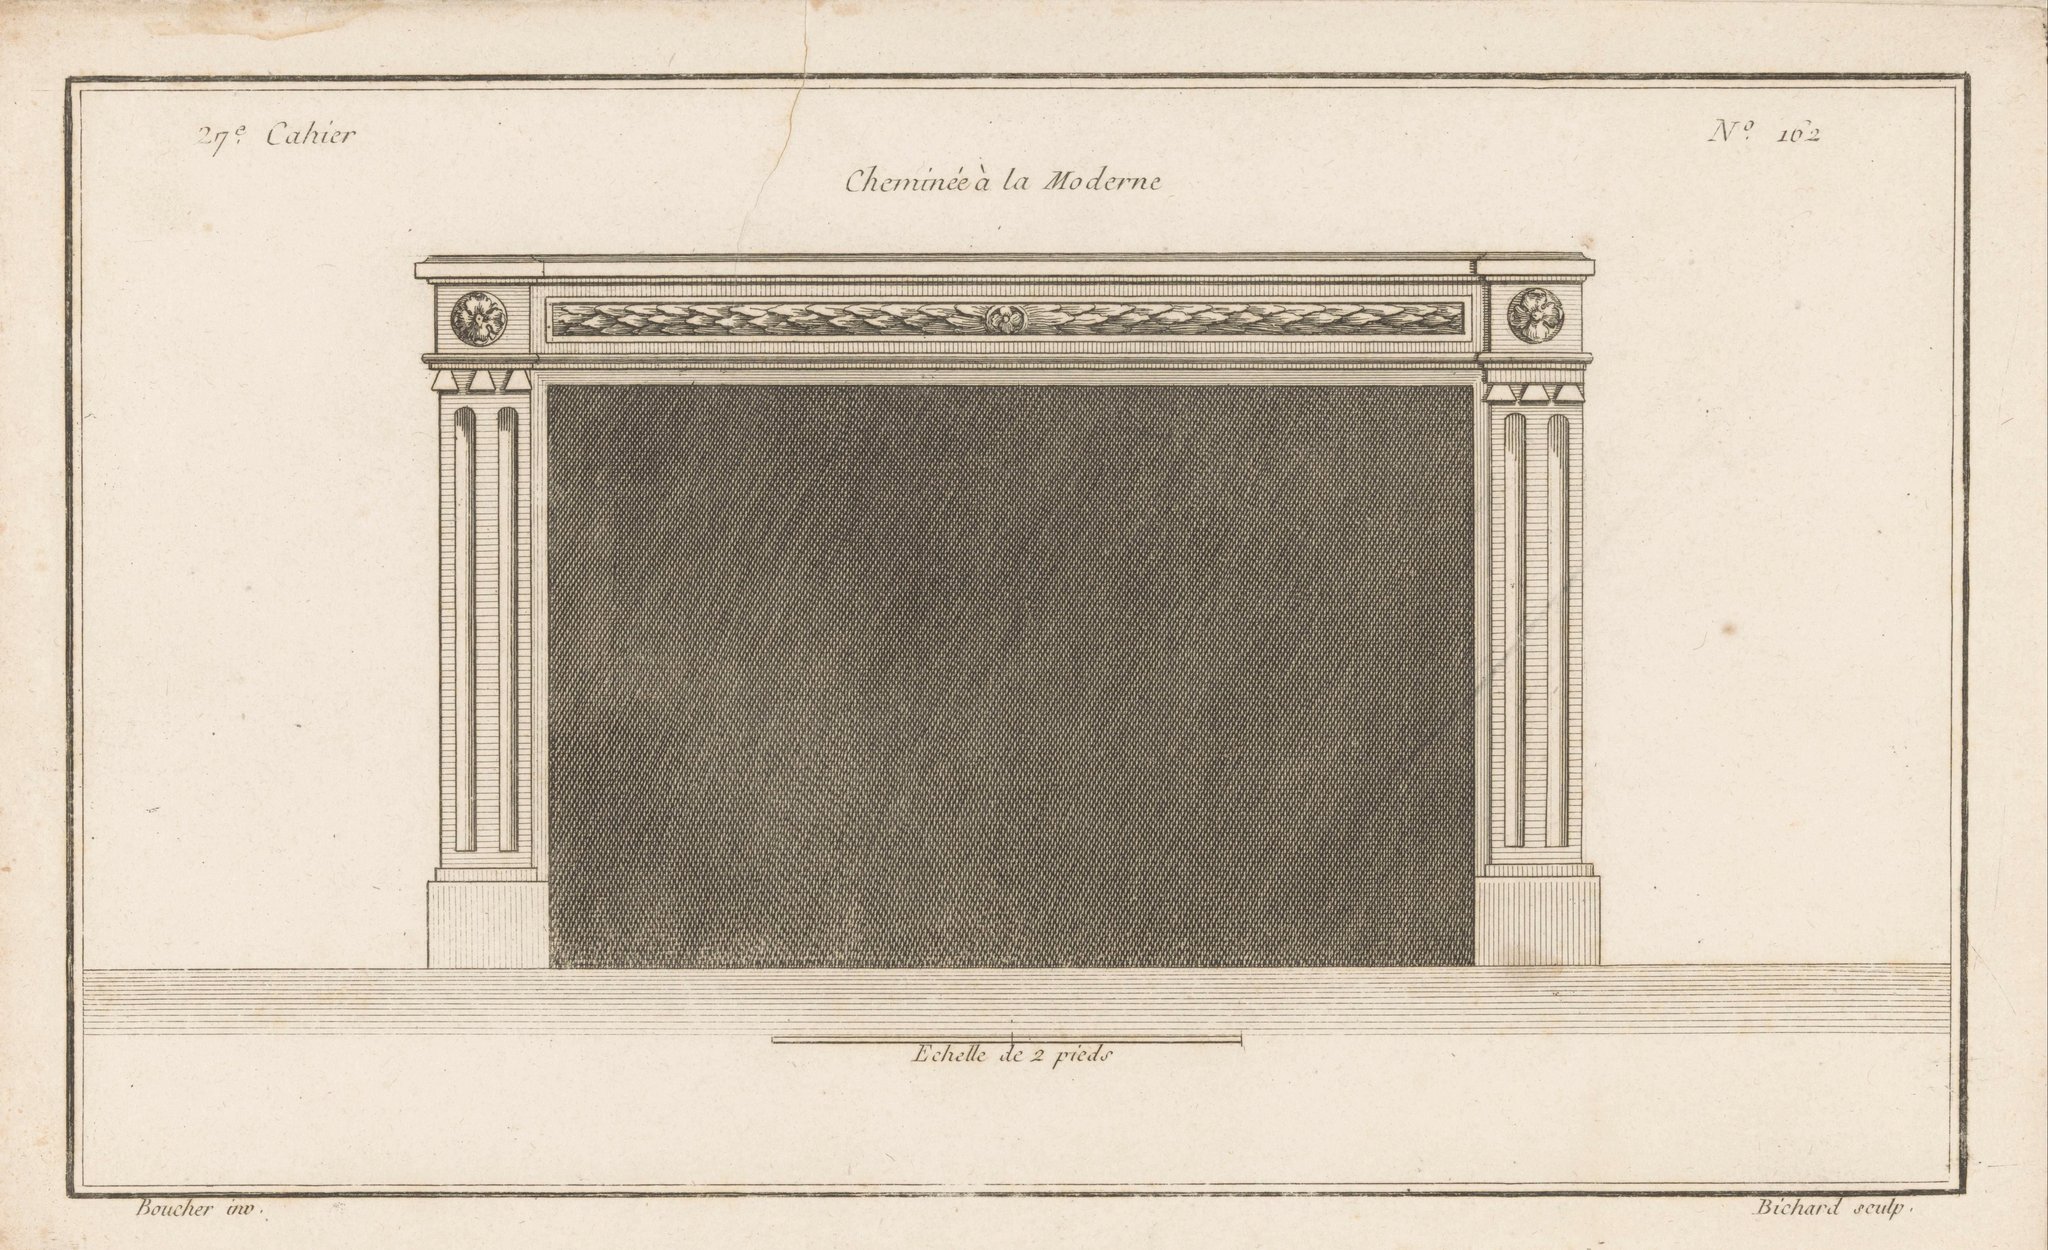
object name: print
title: Haard met blad- en bloemmotieven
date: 1772-1779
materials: paper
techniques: engraving, etching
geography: paris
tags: open hearth, fire-place, ornament derived from plant forms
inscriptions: collector's mark: Lugt 2228, collector's mark: Lugt 2760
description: Een open haard gedecoreerd met blad- en bloemmotieven. Prentnummer 162.